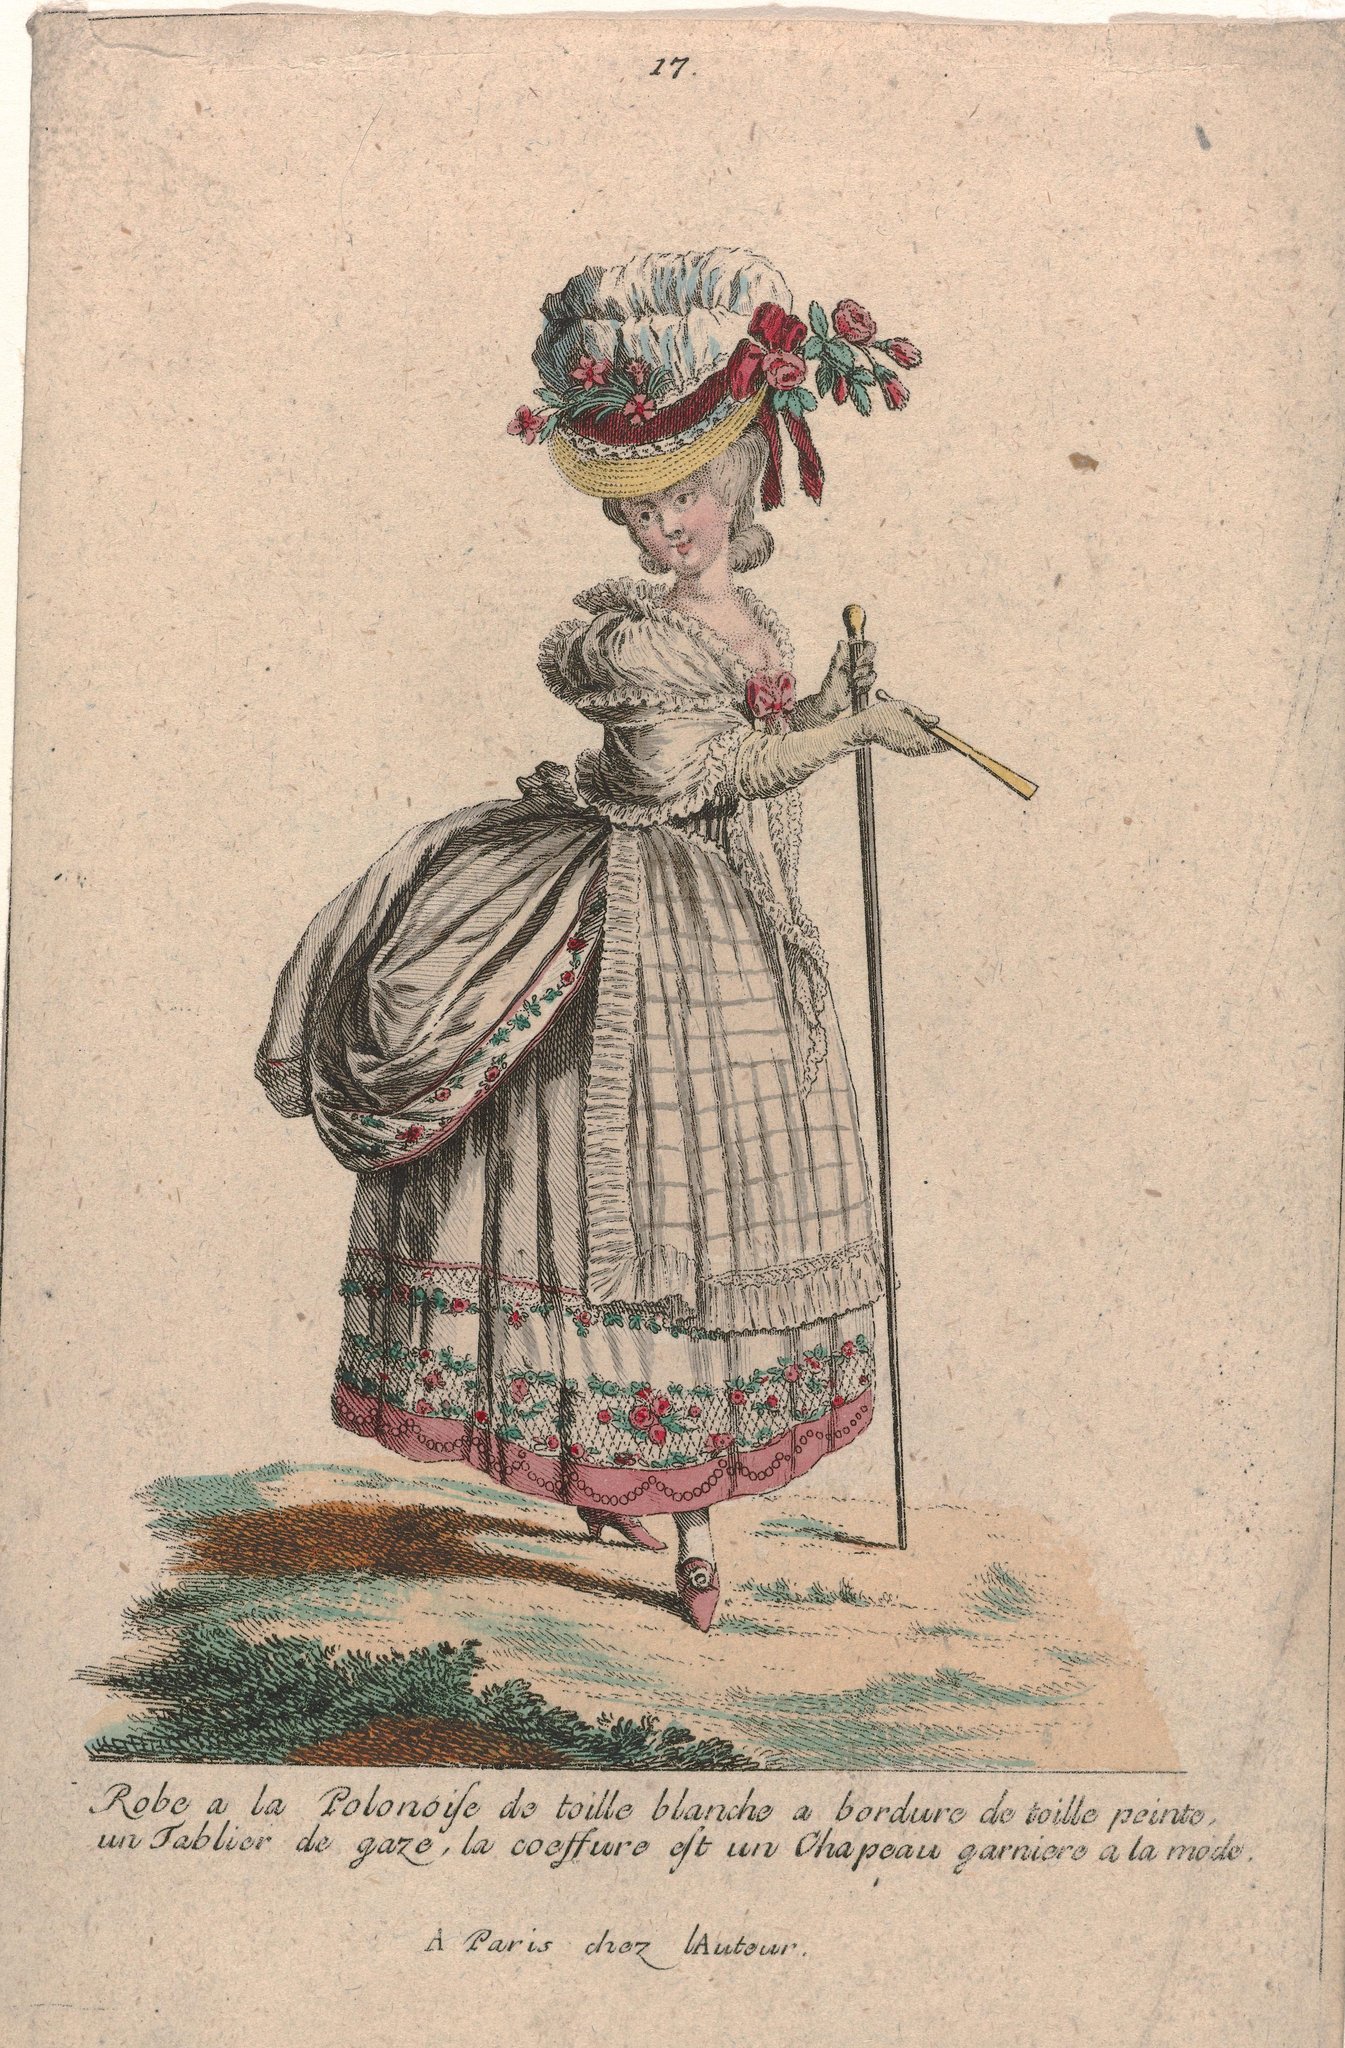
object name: fashion print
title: Gallerie des Modes et Costumes Français, 1785, nr. 17, nr. 33, Kopie naar Y 134 : Robe a la Polonoise de toille blanch (...)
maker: pierre gleich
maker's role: print maker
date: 1785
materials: paper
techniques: engraving, hand coloring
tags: gloves, mittens (long gloves) (+ women's clothes), walking-stick, staff, cane (+ women's clothes), clothing for the upper part of the body (mantelet) (+ women's clothes), fashion plates, head-gear: hat (+ women's clothes), shoes, sandals (+ women's clothes), skirt (+ women's clothes), fan (+ women's clothes), apron (+ women's clothes), dress, gown: robe à la polonaise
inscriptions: caption: ‘Robe a la Polonoise de toille blanche a bordure de toille peinte, un Tablier de gaze, la coeffure est un Chapeau garniere a la mode.’, caption: ‘A Paris chez l'Auteur.’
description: Vrouw gekleed in een 'robe à la polonaise' van witte 'toille' (linnen of katoen) met een rand van beschilderde 'toille' (linnen of katoen) met bloemmotief. Kleine schoudermantel met capuchon. Sierschort van tule. Op het hoofd een hoed gegarneerd naar de laatste mode. Verdere accessoires: lange handschoenen, waaier, wandelstok met gouden knop, schoenen met hakken. Kopie naar Y 134 uit serie Y. 23e Cahier de Costumes Français, 17e Suite d'Habillemens à la mode en 1779, Gallerie des Modes et Costumes Français.